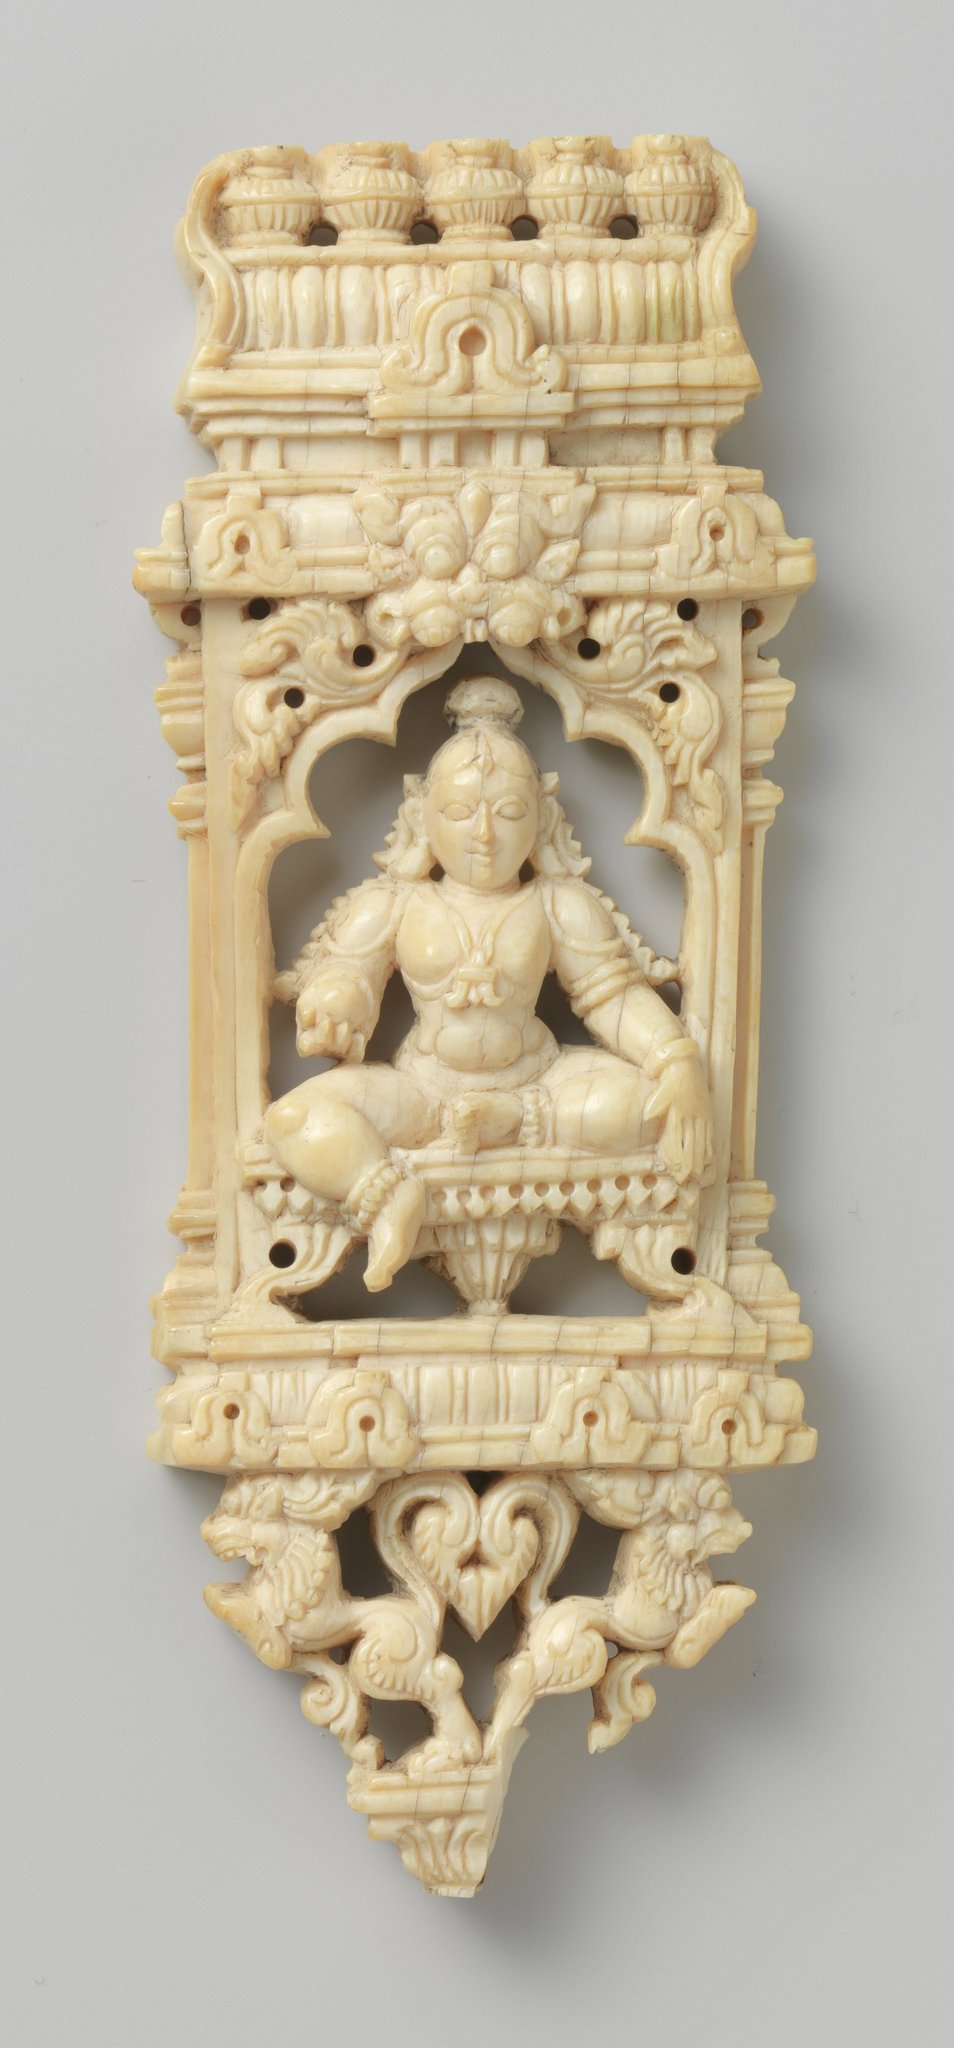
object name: ornament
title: Ornament with Krishna as a child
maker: Anonymous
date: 1600-1699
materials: ivory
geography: south india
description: The popular deity is represented as a plump toddler holding a pat of butter, which he has stolen from his mother while she churned milk. Krishna grew up among cowherds and milkmaids in the woods by the River Yamuna